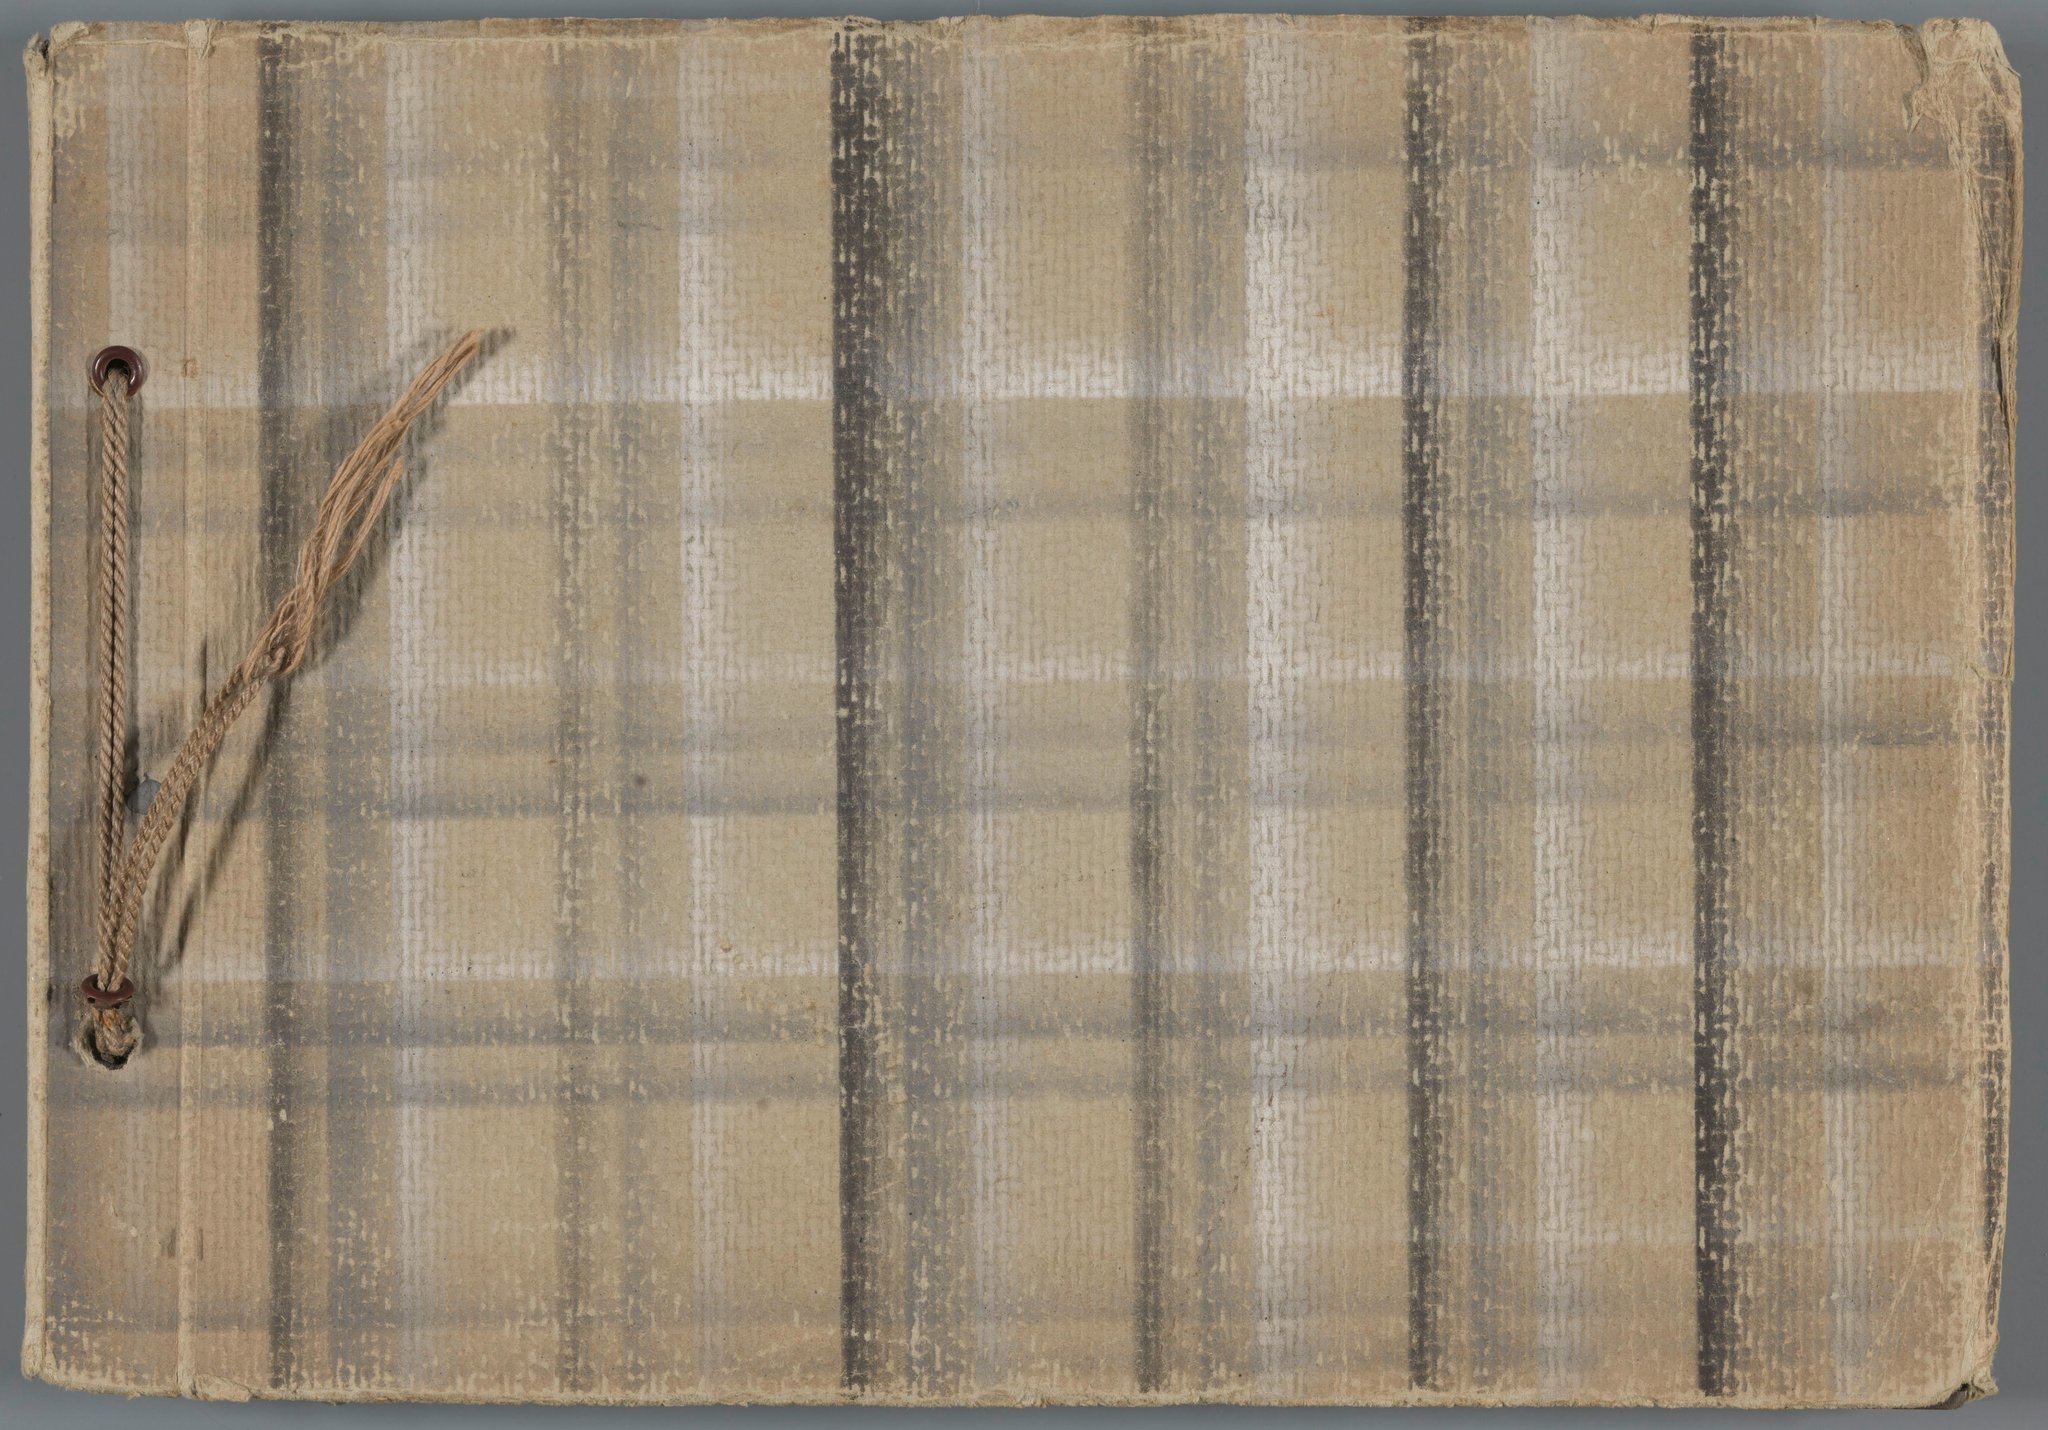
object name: photograph album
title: Fotoalbum van de schooljaren Frank Willem van den Berg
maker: frank willem van den berg (1912-1998)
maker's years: 1912-1998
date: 1923-1931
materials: paper, cardboard, ink, metal, textile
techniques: gelatin silver print, pen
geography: amsterdam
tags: the family travelling, on holiday, sailing-ship, sailing-boat, friends, netherlands, france, switzerland, england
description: Plakboek met 190 foto's, verdeeld over 42 pagina's en de binnenzijden van het voor- en achterplat. Vier foto's en een fotomechanische afdruk zitten los in het album. Gefotografeerd zijn Frank Willem van den Berg met groepen vrienden, diverse vakanties zoals naar Zwitserland, Frankrijk en Engeland, en zeiltochten met vrienden. De meeste foto's zijn door Frank Willem van den Berg zelf gemaakt of door mensen uit zijn omgeving; daarnaast bevat het album op reis gekochte prentbriefkaarten. De meeste bladzijden bevatten handgeschreven bijschriften.